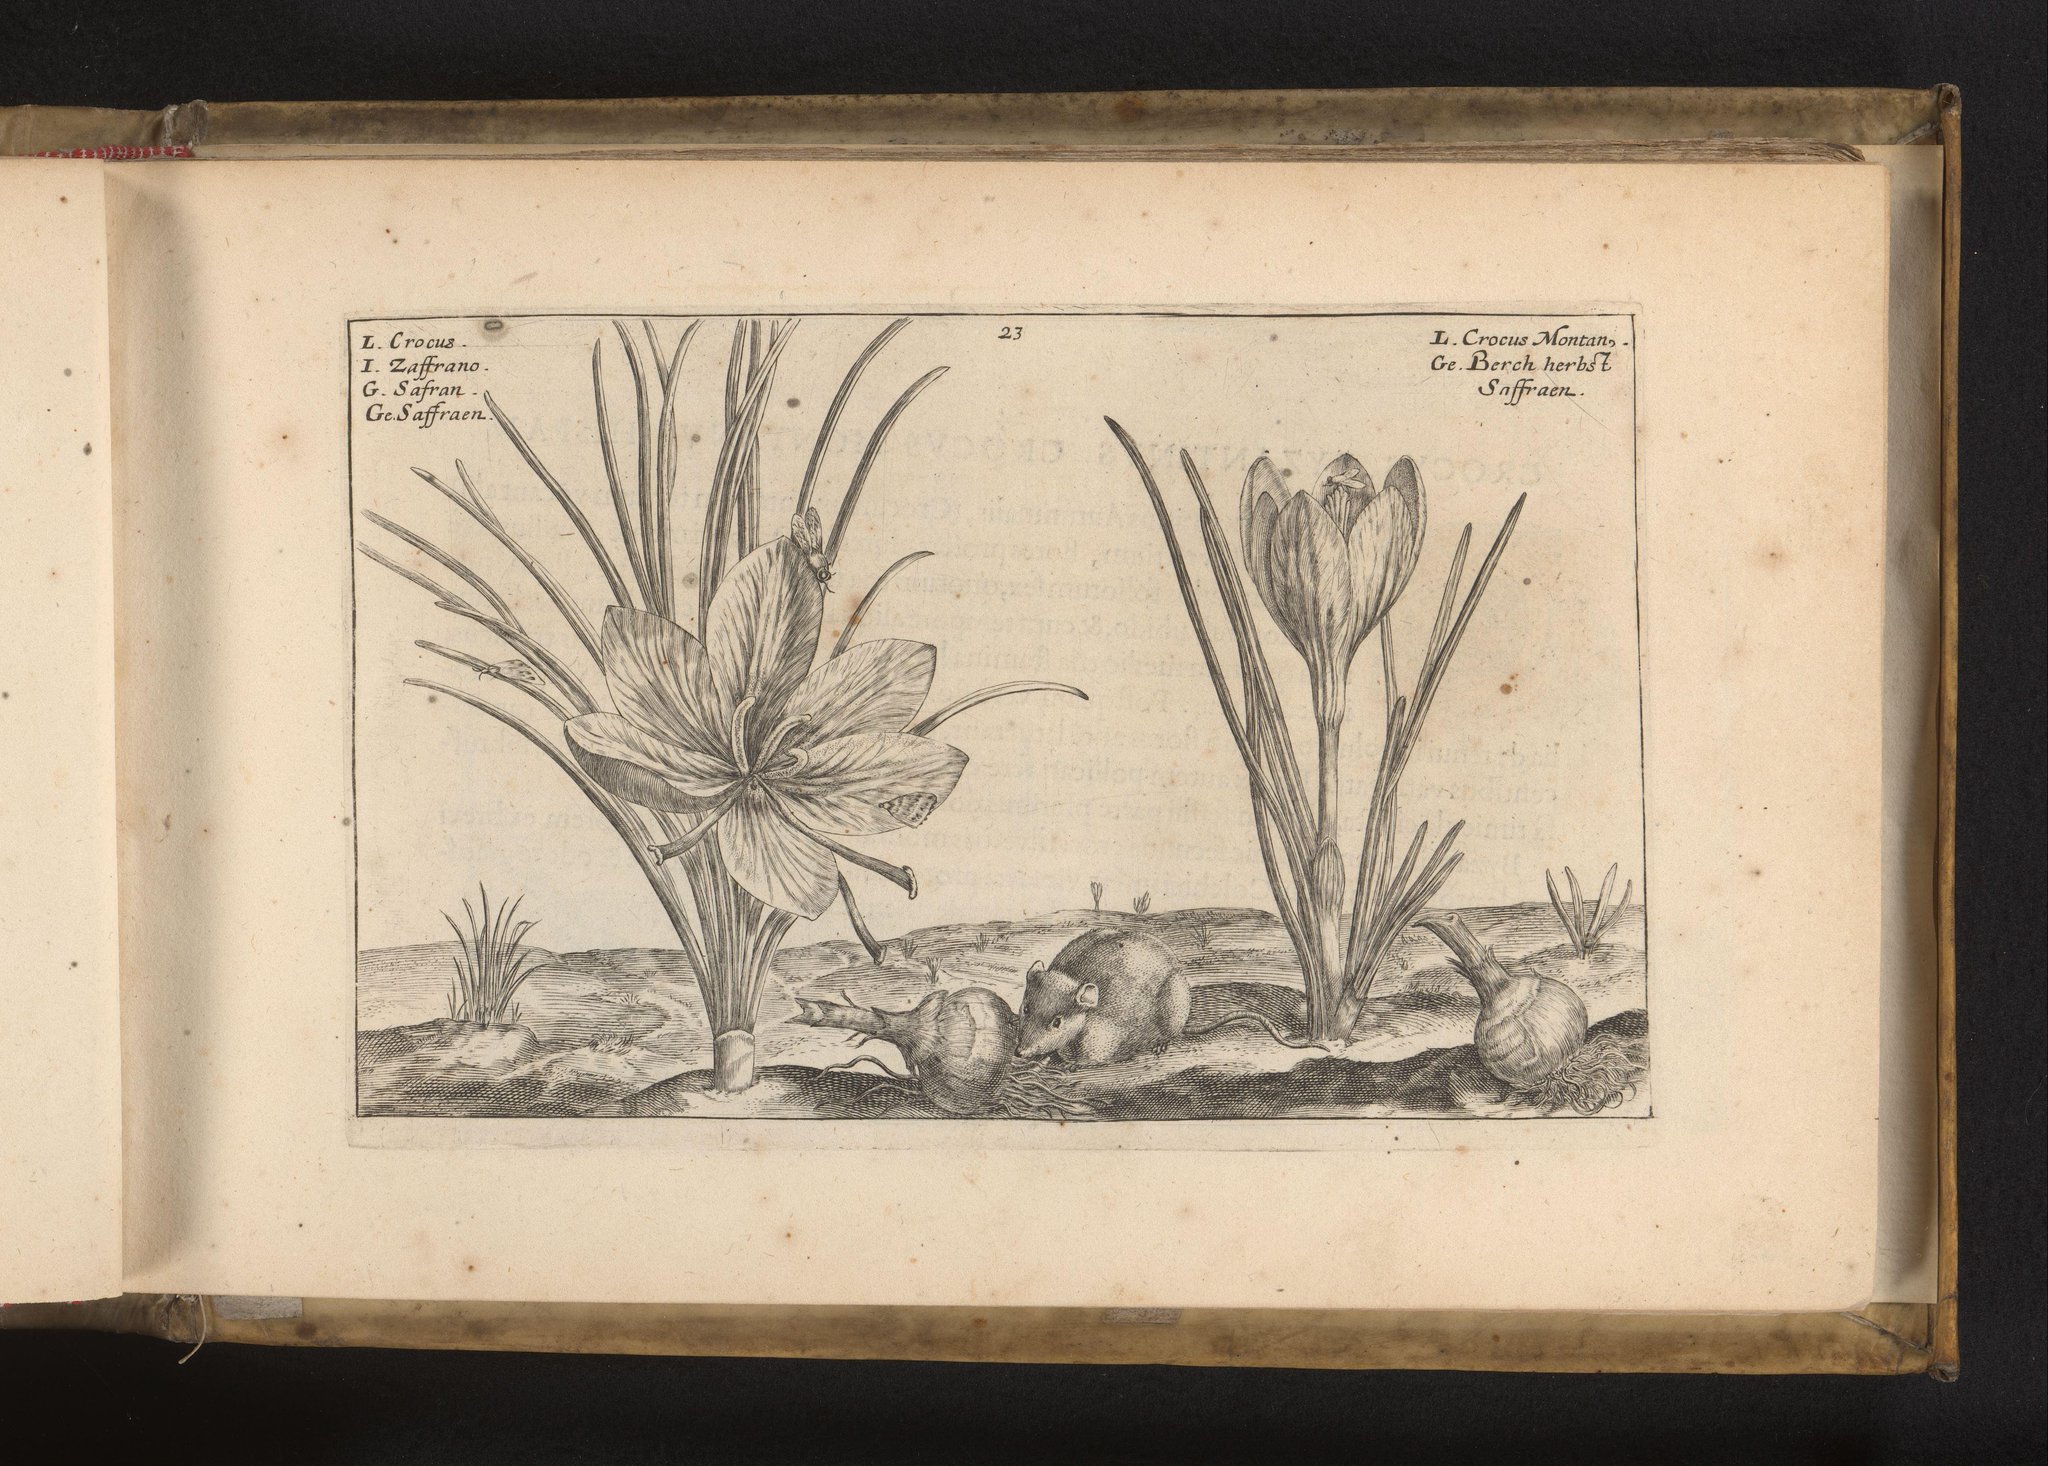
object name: print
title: Bloementuin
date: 1617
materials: paper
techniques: engraving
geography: arnhem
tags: flowers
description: Prent uit: Passe, Crispijn van de (II). Hortus floridus in quo rariorum & minus vulgarium florum icones ad vivam veramque formam. Arnhem: Johannes Janssonius, 1617.